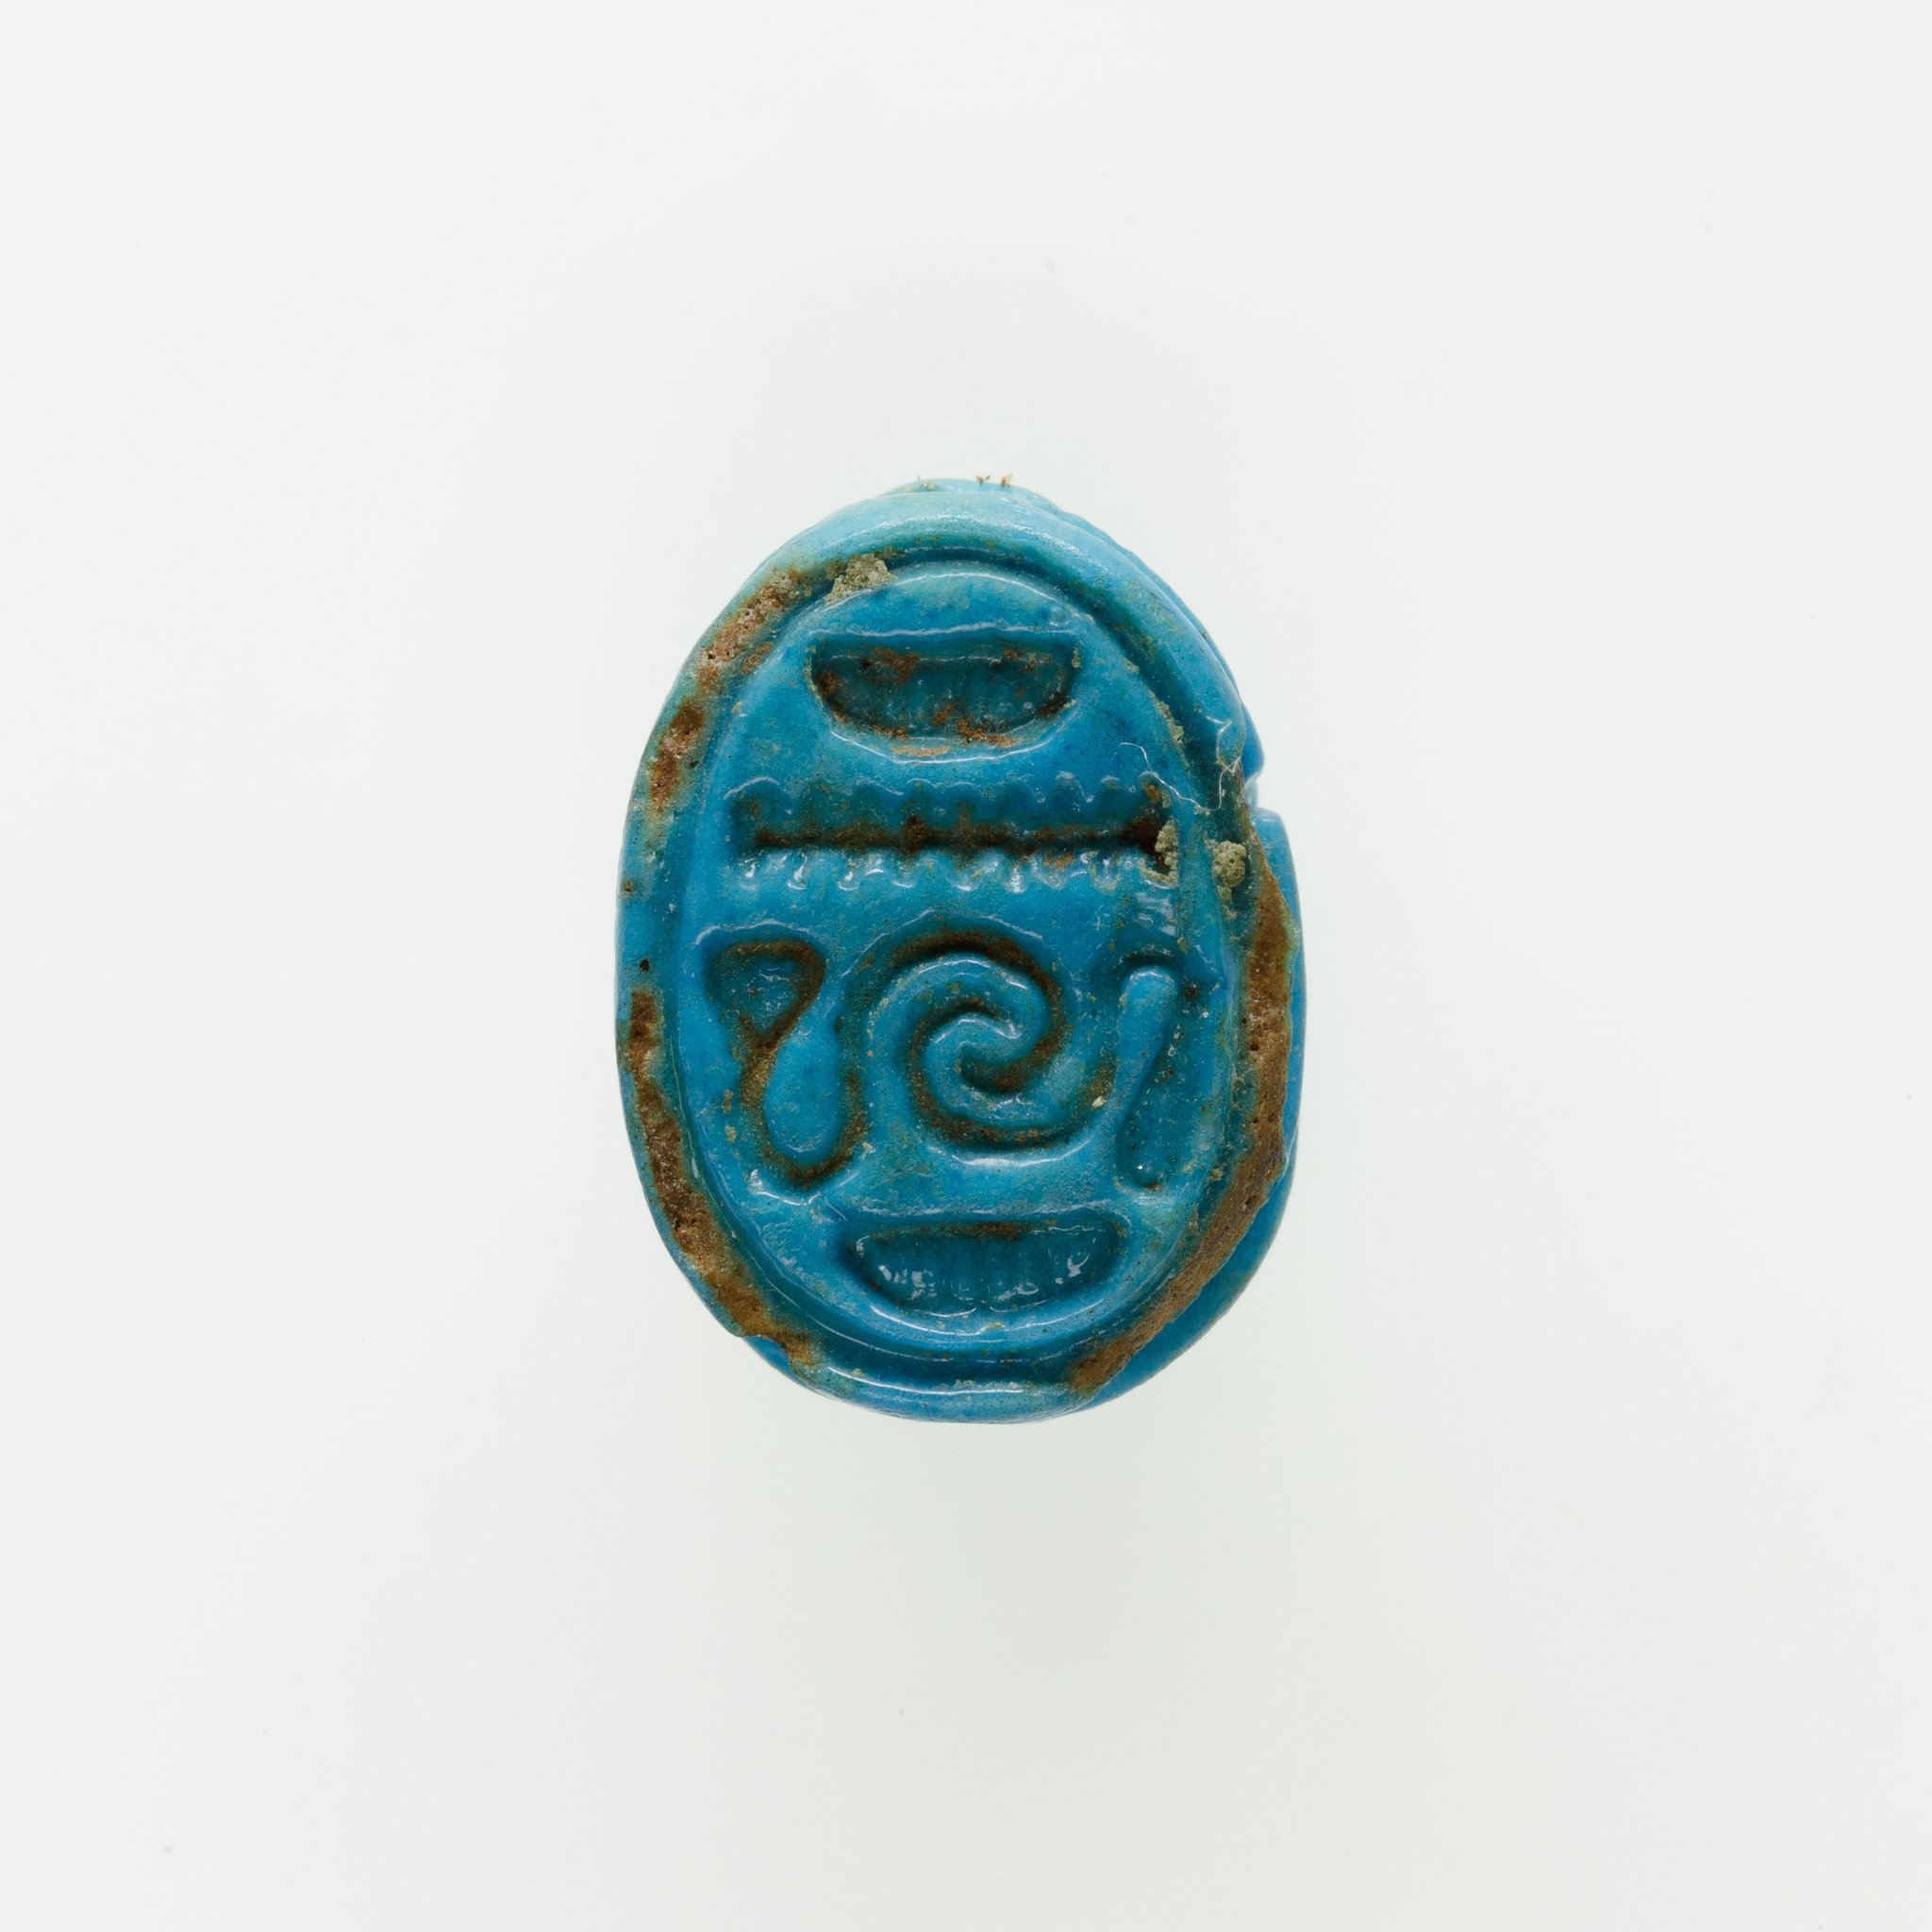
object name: scarab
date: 1492-1473 BCE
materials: faience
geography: egypt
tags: scarabs